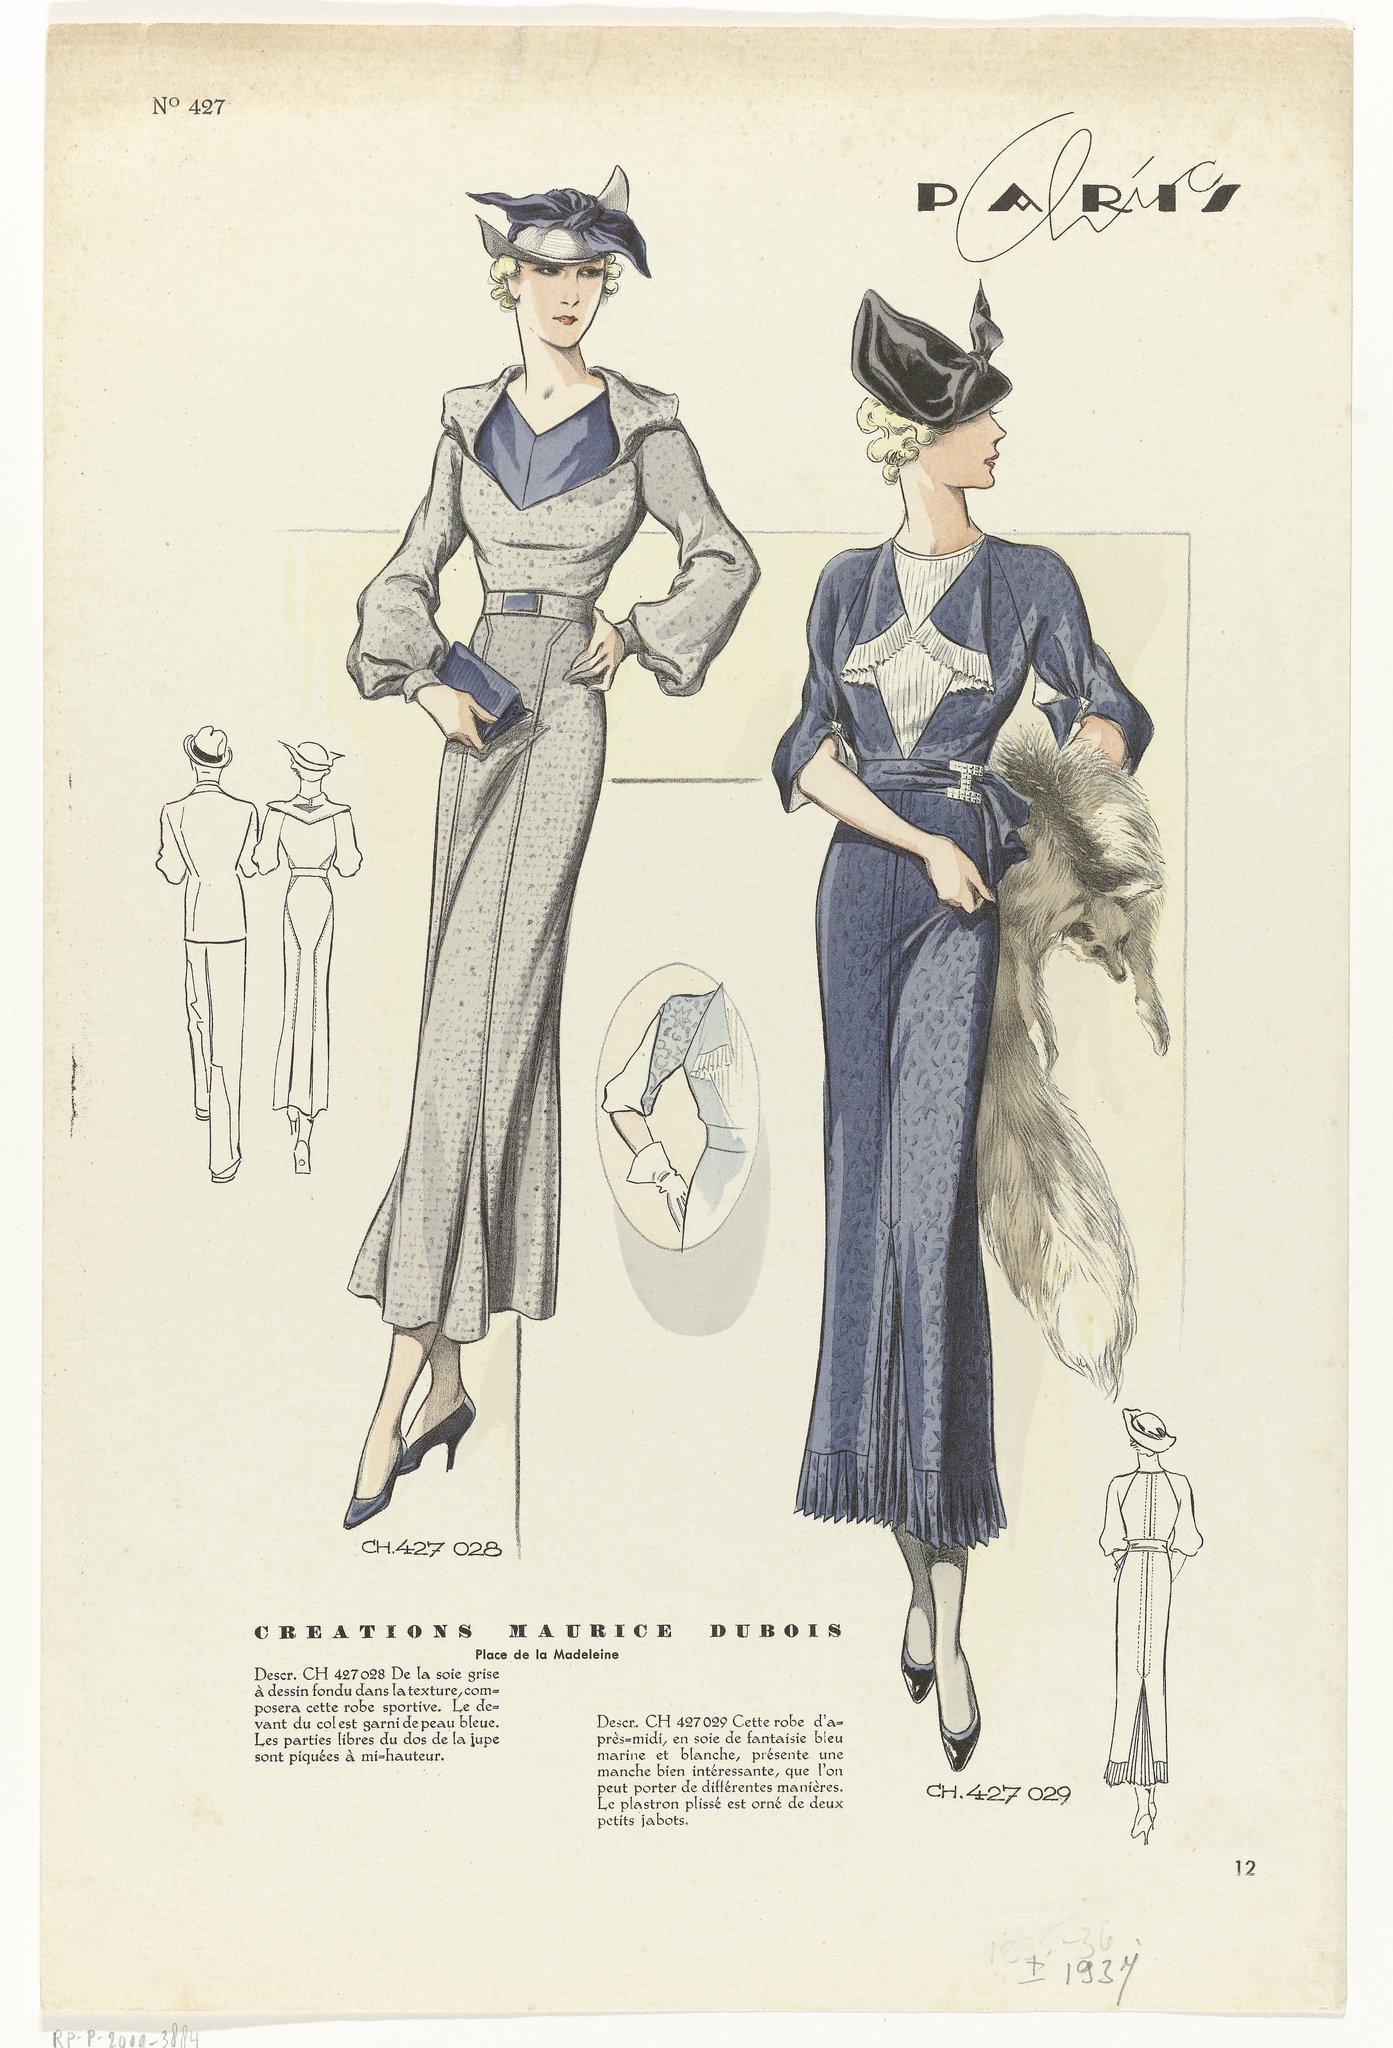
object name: fashion print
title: Paris Chic, No. 427, fig. 28-29 : Creations Maurice Dubois (...)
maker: Anonymous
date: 1937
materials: paper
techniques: hand coloring, lithograph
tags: head-gear: toque (+ women's clothes), bag (clutch) (+ women's clothes), fashion plates, dress, gown (+ women's clothes)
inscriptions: title: ‘Paris Chic’, caption: ‘Creations Maurice Dubois / Place de la Madeleine / Descr. CH 427 028 De la soie grise à dessin fondu dans la texture, composera cette robe sportive. Le devant du col est garni de peau bleue. Les parties libres du dos de la jupe sont piquées à mi-hauteur. / Descr. CH 427 029 Cette robe d'après-midi, en soie de fantaisie bleu marine et blanche, présente une manche bien intéressante, que l'on peut porter de différentes manières. Le plastron plissé est orné de deux petits jabots.’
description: Links: Sportieve japon in grijs, de voorkant van de kraag afgezet met blauw leer. Rechts: avondjapon in blauwe zijde met geplisseerd jabot. Toque op het hoofd, bont over de arm.